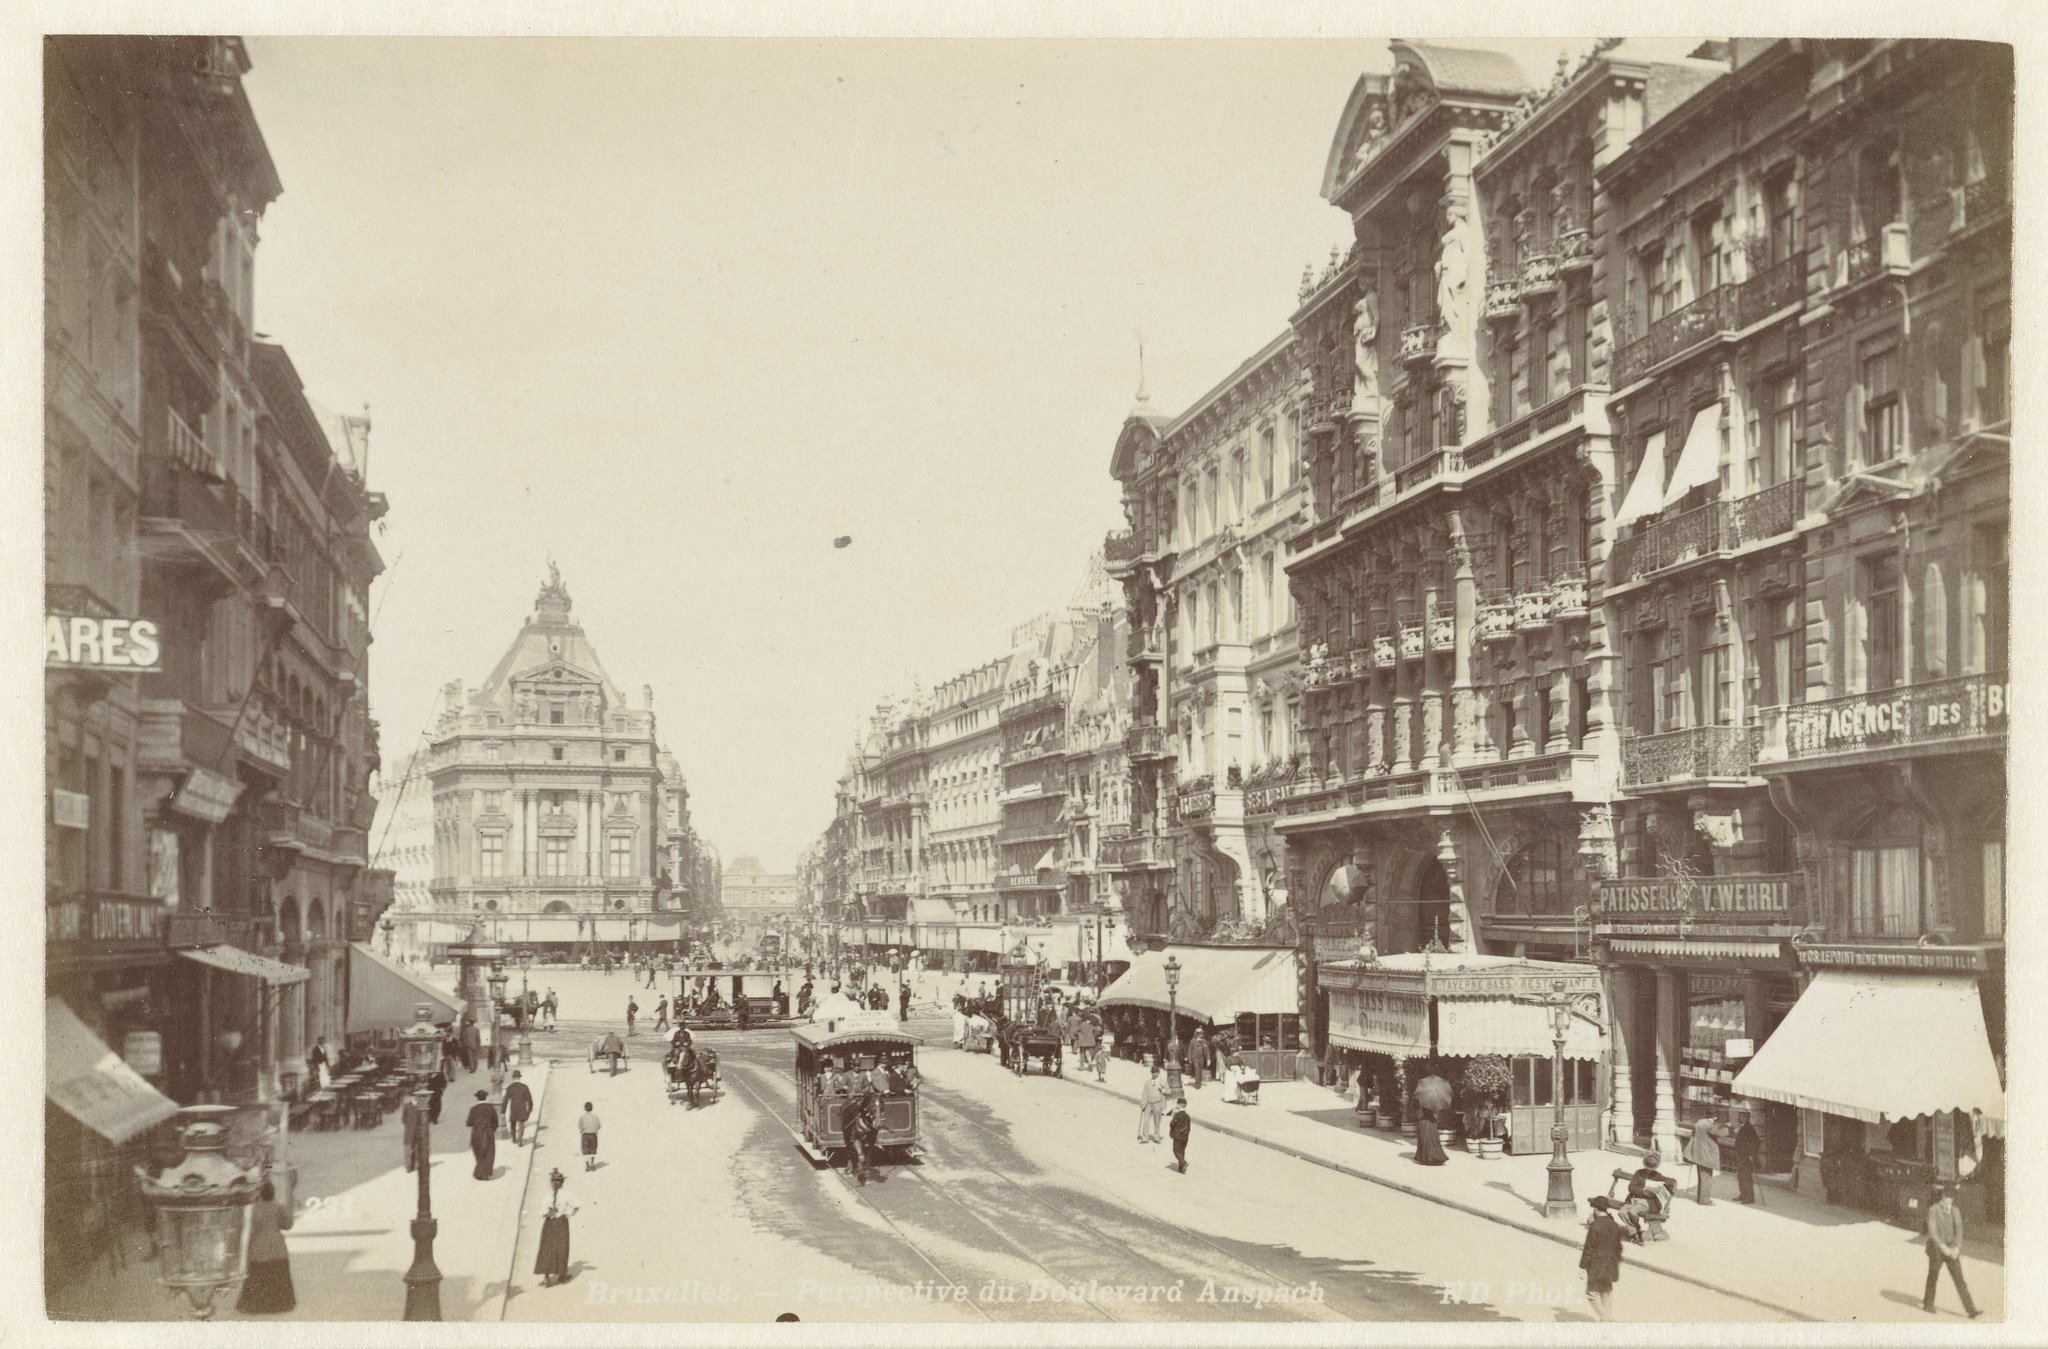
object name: photograph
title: Bruxelles - Perspective du Boulevard Anspach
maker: étienne neurdein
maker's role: publisher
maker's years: 1832-1918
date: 1860-1900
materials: paper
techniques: albumen print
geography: brussels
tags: avenue, boulevard, promenade, esplanade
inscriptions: signature: ‘231/ ND Phot’, title: ‘Bruxelles - Perspective du Boulevard Anspach’